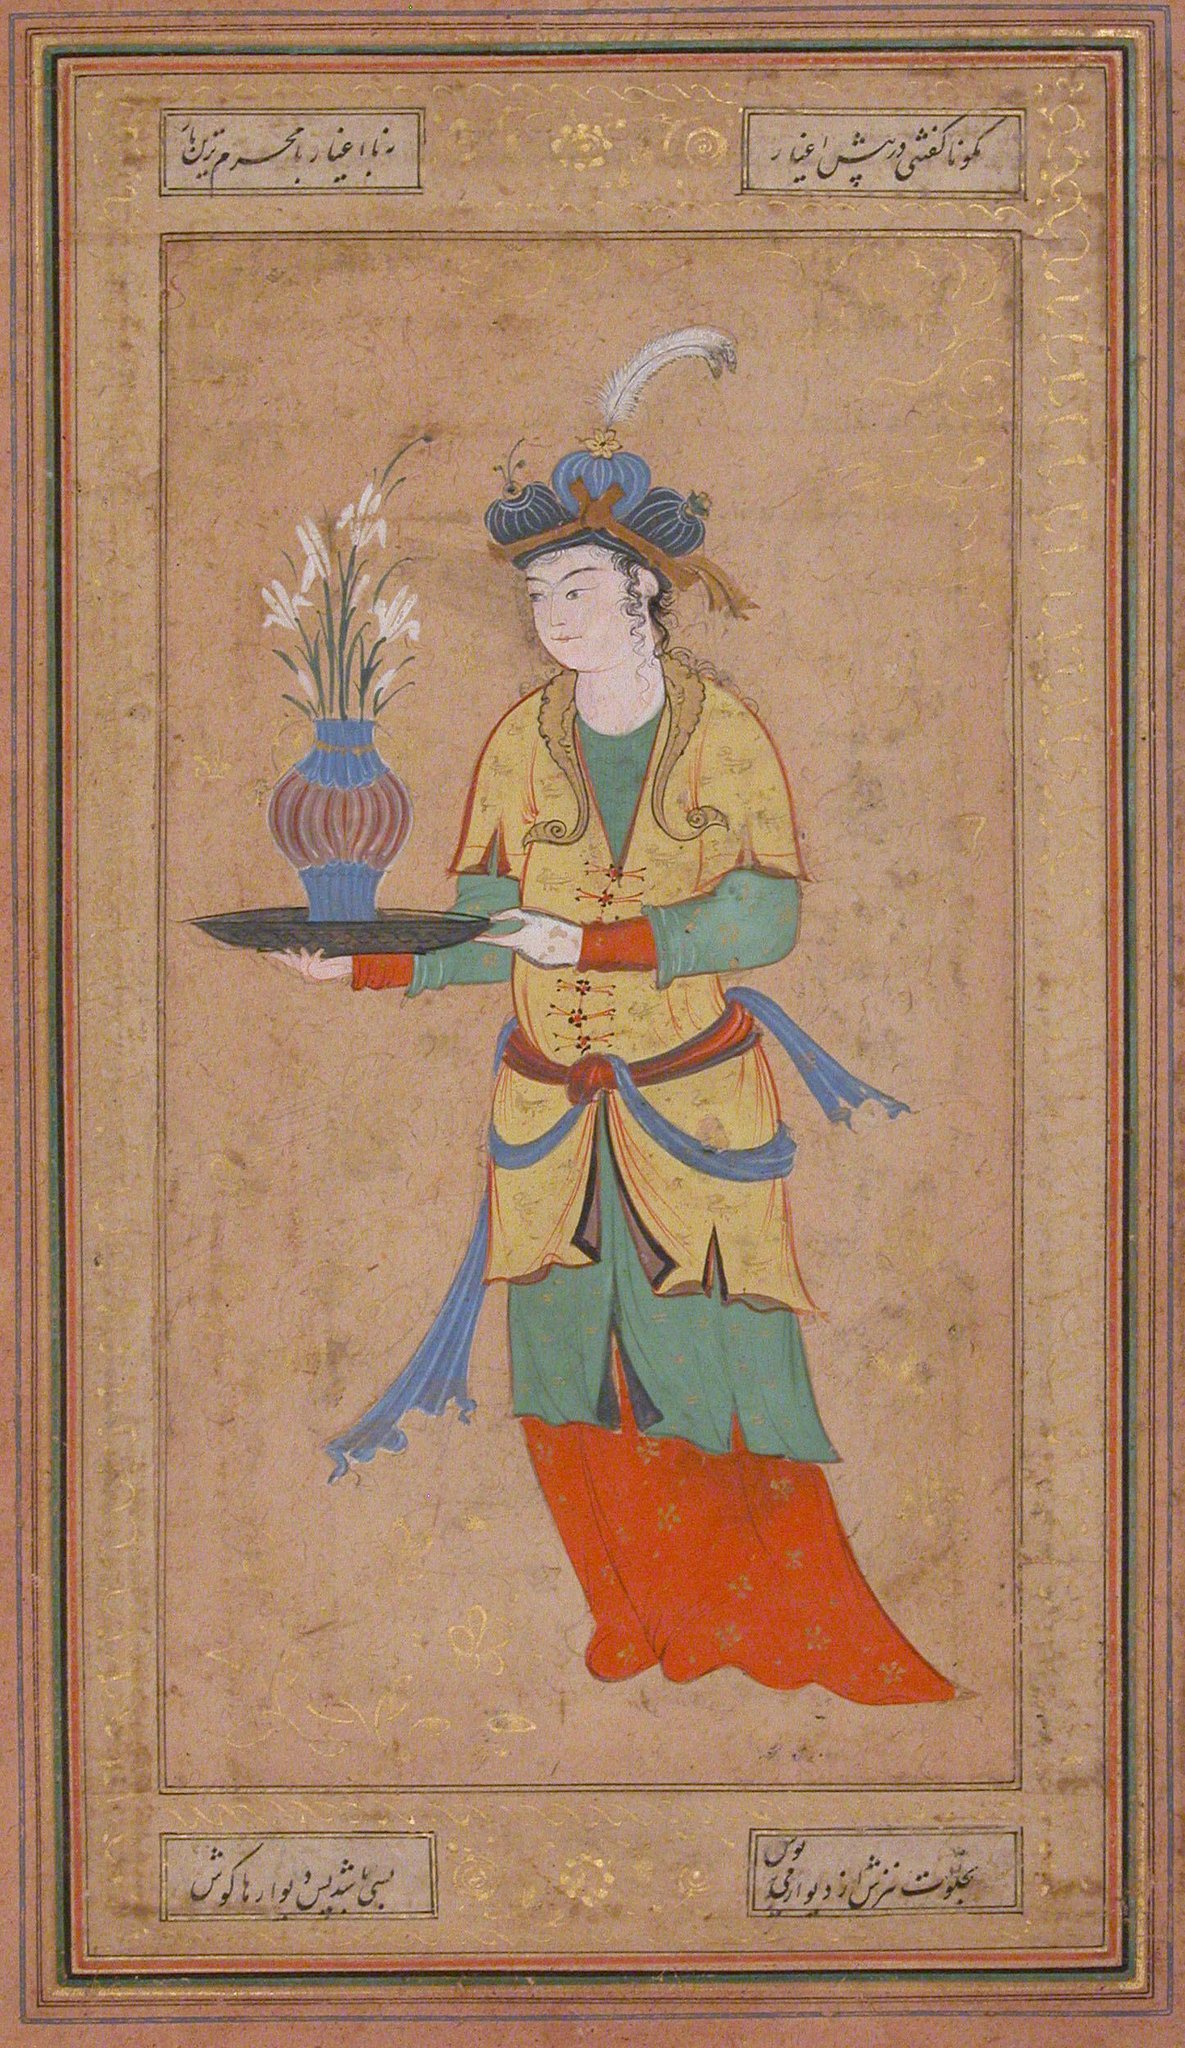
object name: illustrated single work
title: Woman with Vase of Lilies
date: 1551-1600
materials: gold, paper, watercolor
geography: iran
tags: women,lilies